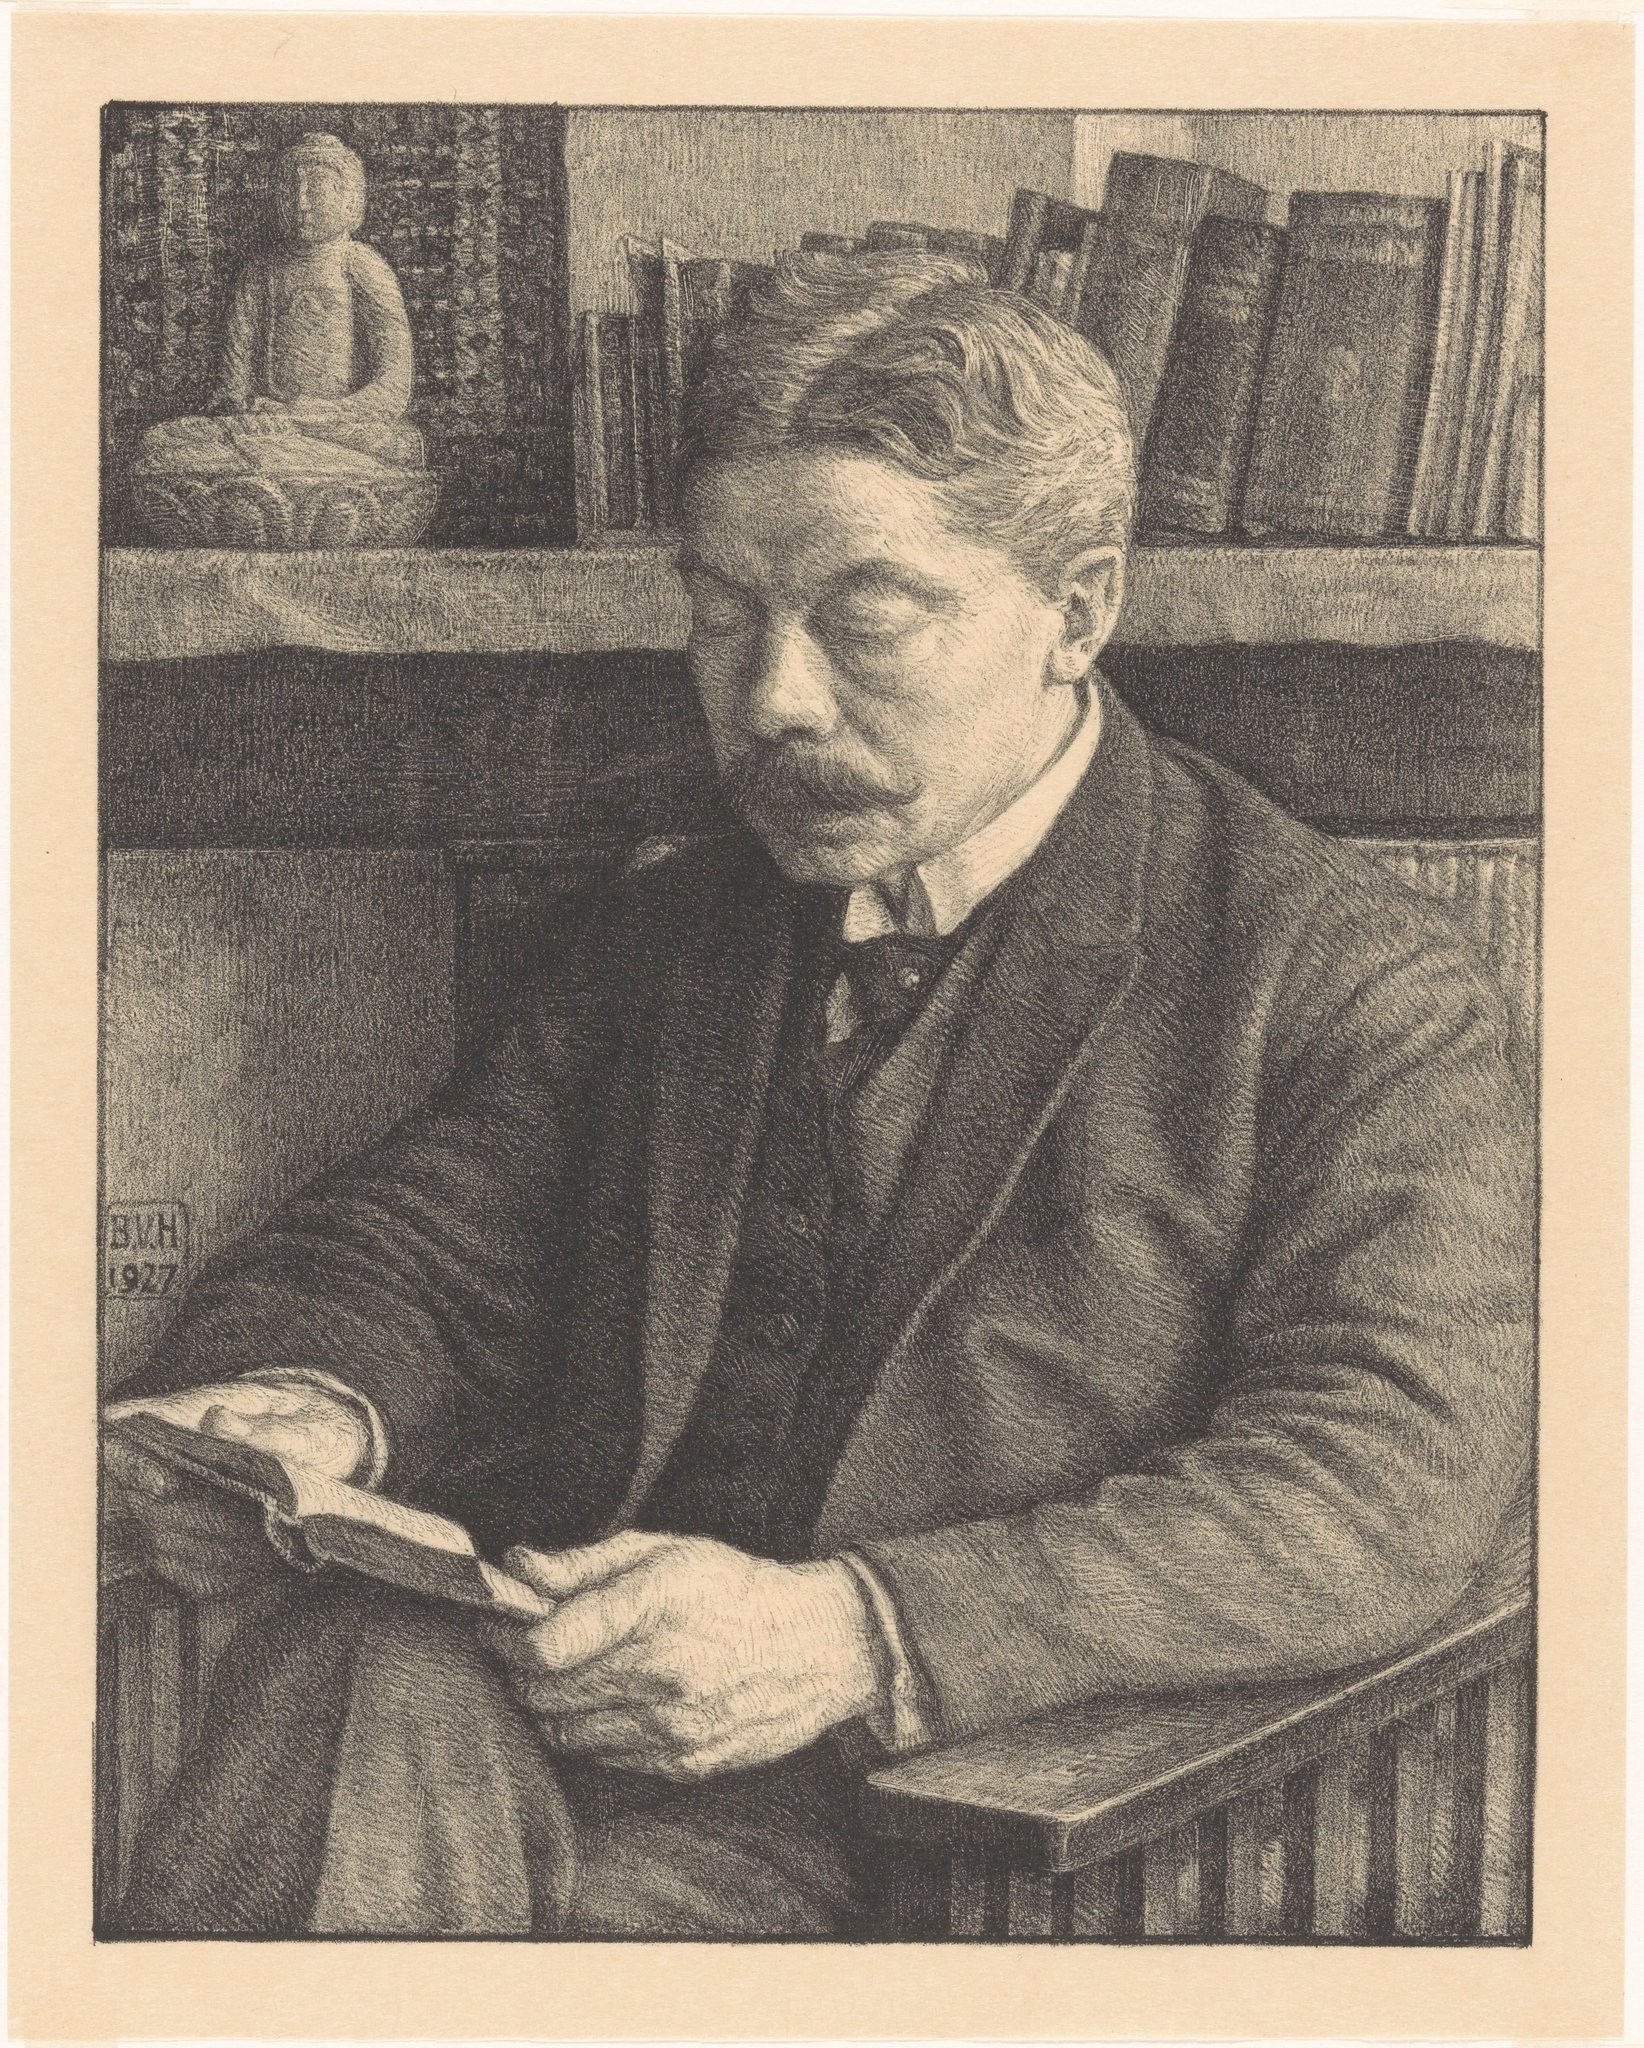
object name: print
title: Portret van ds. J. Dekker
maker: bertha van hasselt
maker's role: print maker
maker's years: 1878-1932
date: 1927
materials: paper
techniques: lithograph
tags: reading, book, statues, paintings, etc. ~ objects of worship (hinduism, buddhism, jainism)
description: Portret van een man met een snor, lezend in een stoel. Op de achtergrond boeken en een boeddhabeeld op een schoorsteenmantel of vensterbank.